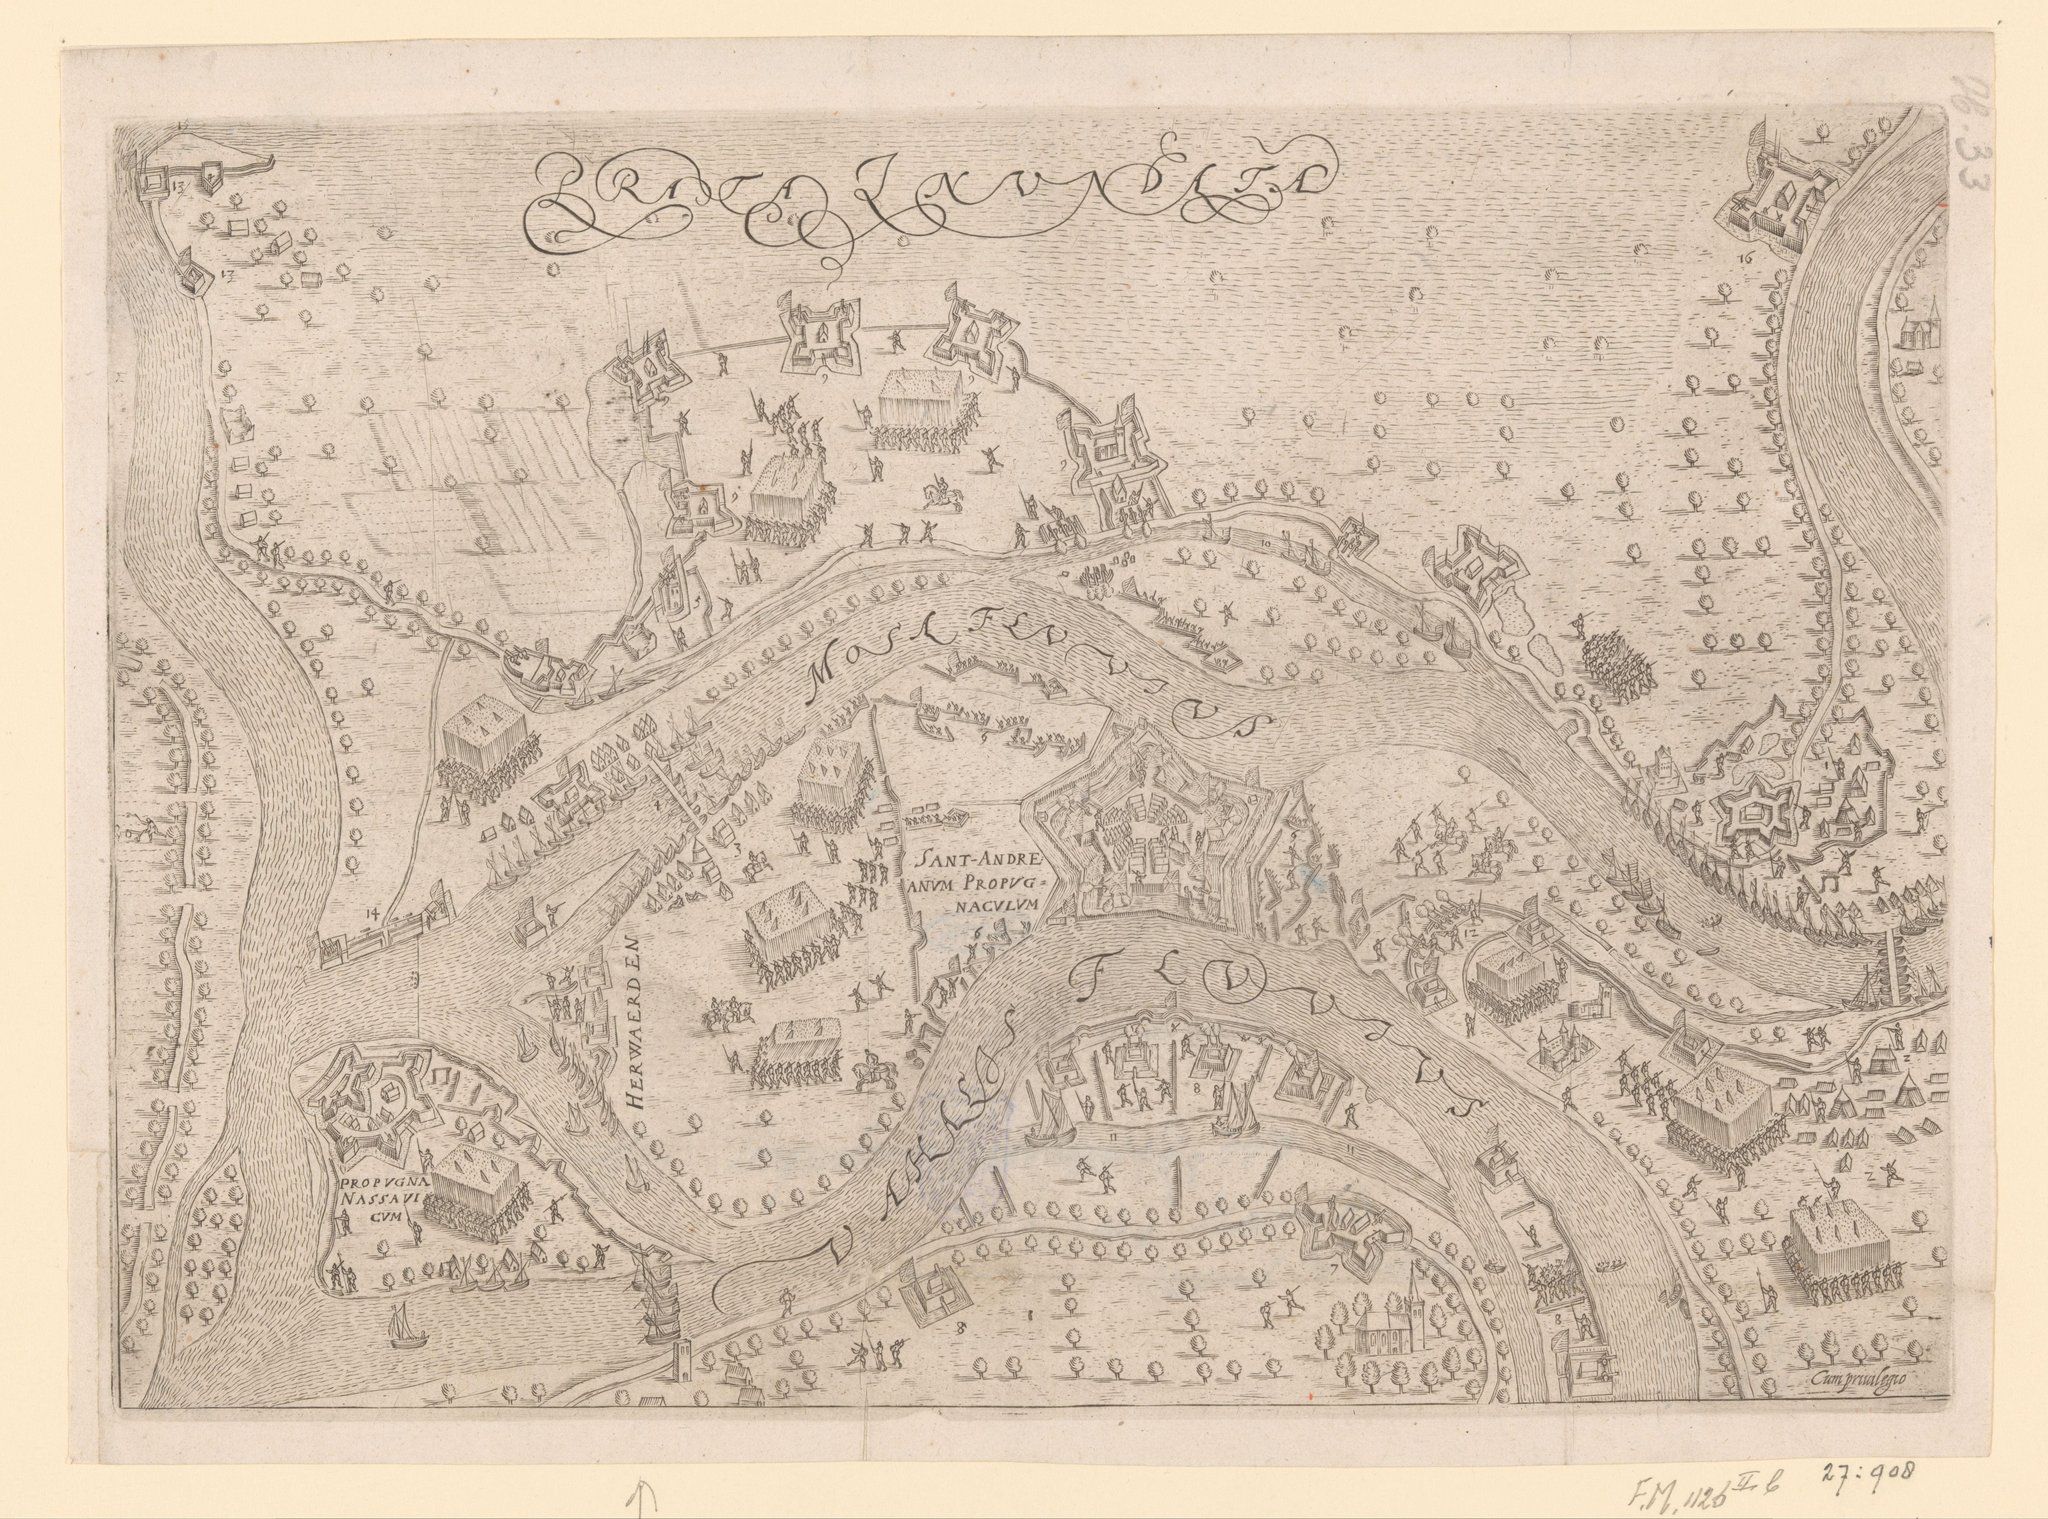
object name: print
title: Beleg en inname van Sint-Andries door Maurits, 1600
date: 1600-1610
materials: paper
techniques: engraving, etching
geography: leiden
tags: delft, the hague, frederick henry (prince of orange), maurice (prince of orange), capture of city (after the siege)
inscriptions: collector's mark: Lugt 3687, collector's mark: Lugt 2228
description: Plan van het gebied tussen de Maas en Waal met de schansen Sint-Andries en Voorne, belegerd en veroverd door het Staatse leger onder Maurits, Frederik Hendrik en Lodewijk Gunther, mei 1600.